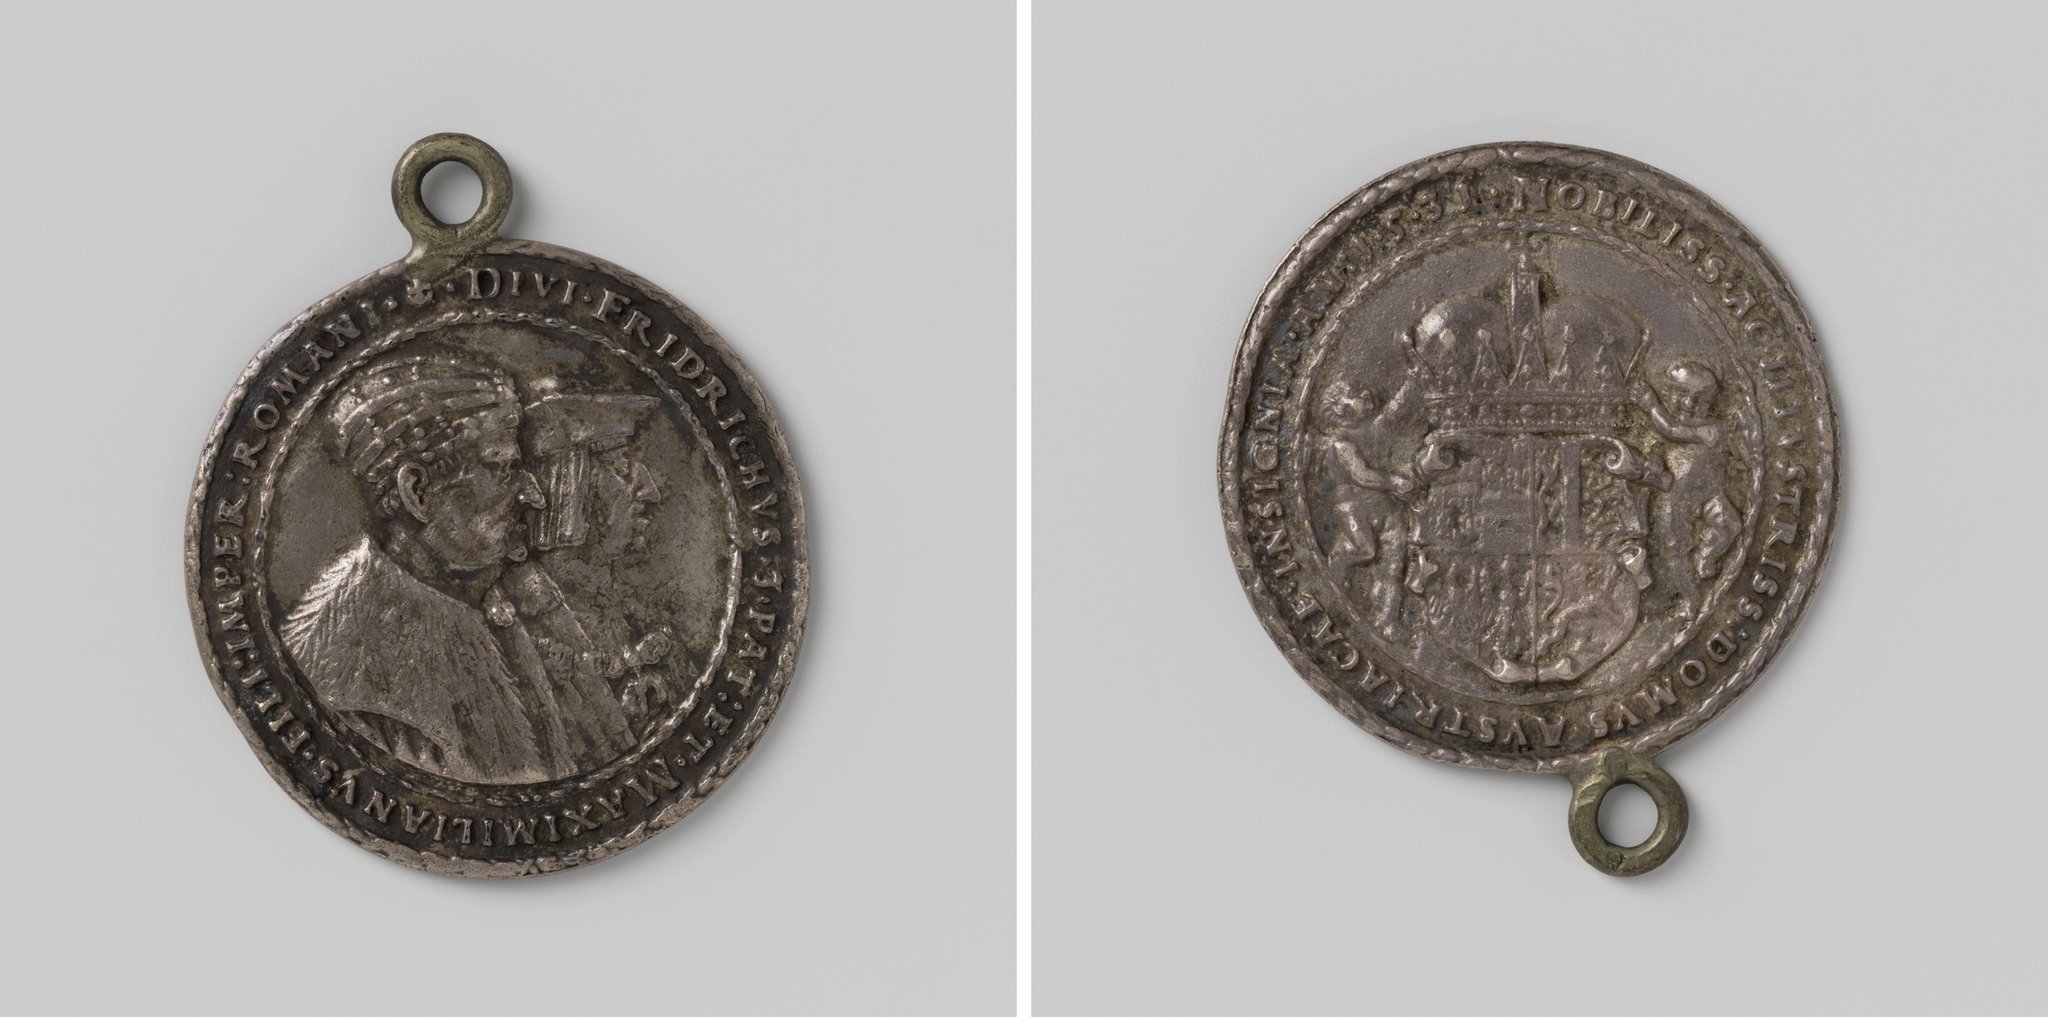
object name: history medal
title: Verheffing van Ferdinand tot Rooms koning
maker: ulrich gebhart (utz)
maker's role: die cutter, mintmaster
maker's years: 1479-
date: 1531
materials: silver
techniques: striking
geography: zwickau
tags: ghent, charles v (holy roman emperor and king of spain), vienna, ferdinand i van habsburg (duits keizer)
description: Zilveren penning met draagoog. Voorzijde: borststukken van twee gekroonde mannen binnen lauwerkrans en omschrift met lauwerkrans. Keerzijde: gekroond wapenschild, geflankeerd door twee engeltjes binnen lauwerkrans en omschrift met lauwerkrans